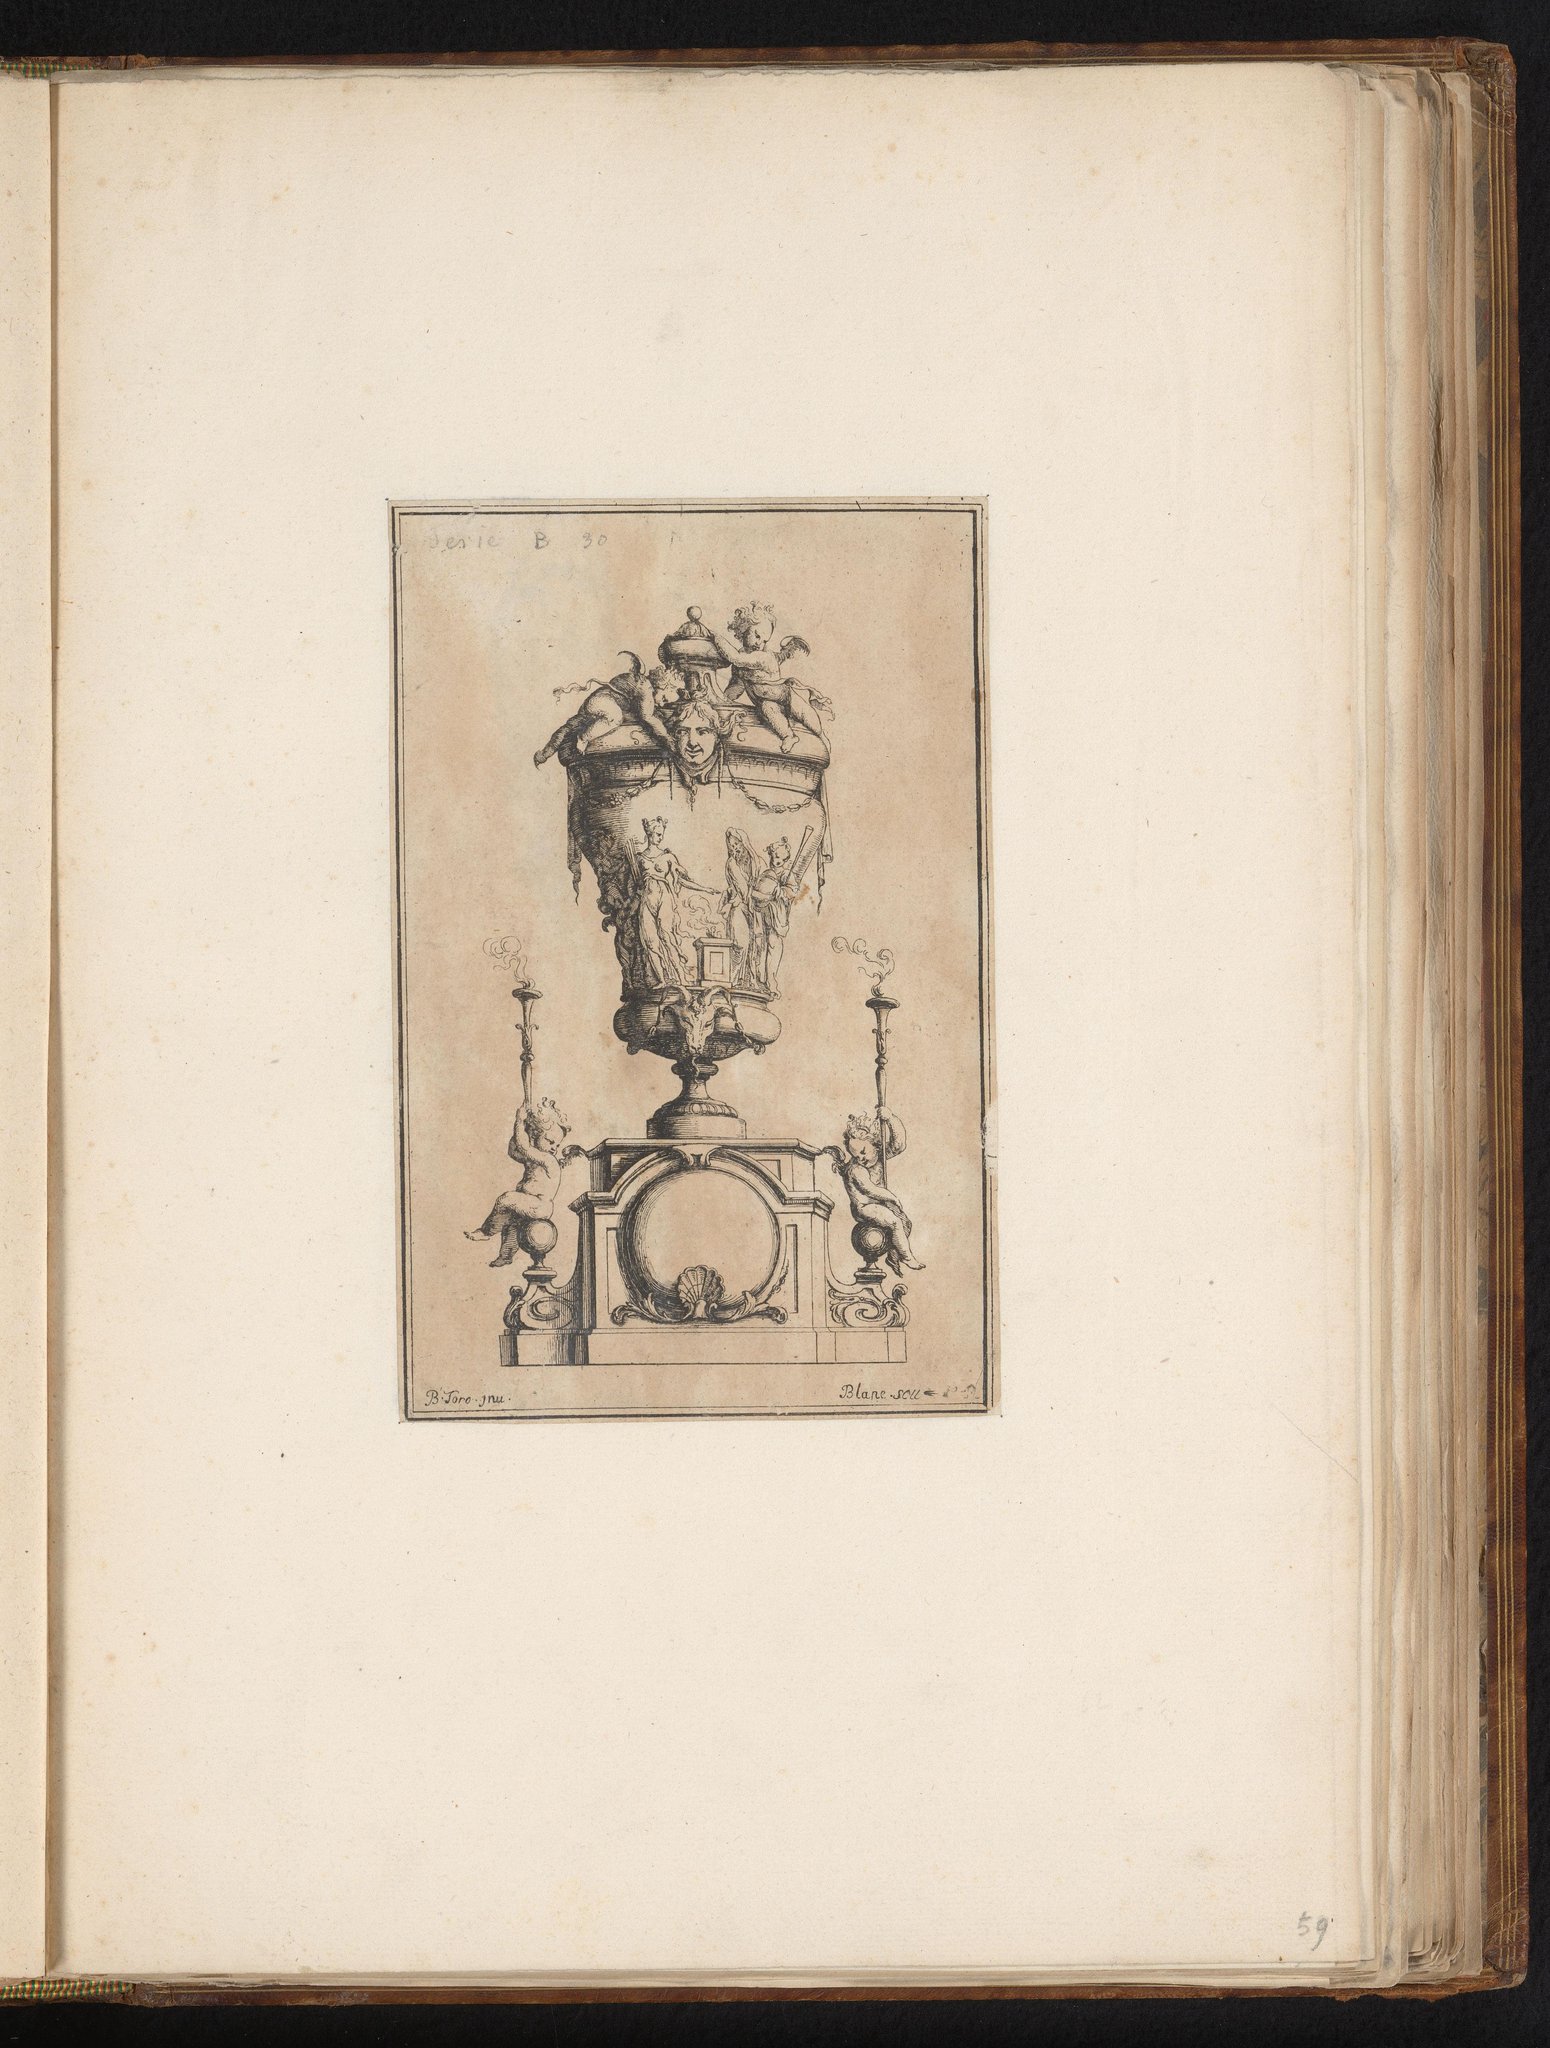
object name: ornament print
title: Titelprent met vaas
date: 1682-1734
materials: paper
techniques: etching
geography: france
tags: vase ~ ornament, cupids: 'amores', 'amoretti', 'putti', garden vase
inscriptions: collector's mark: Lugt 2228, collector's mark: Lugt 2760